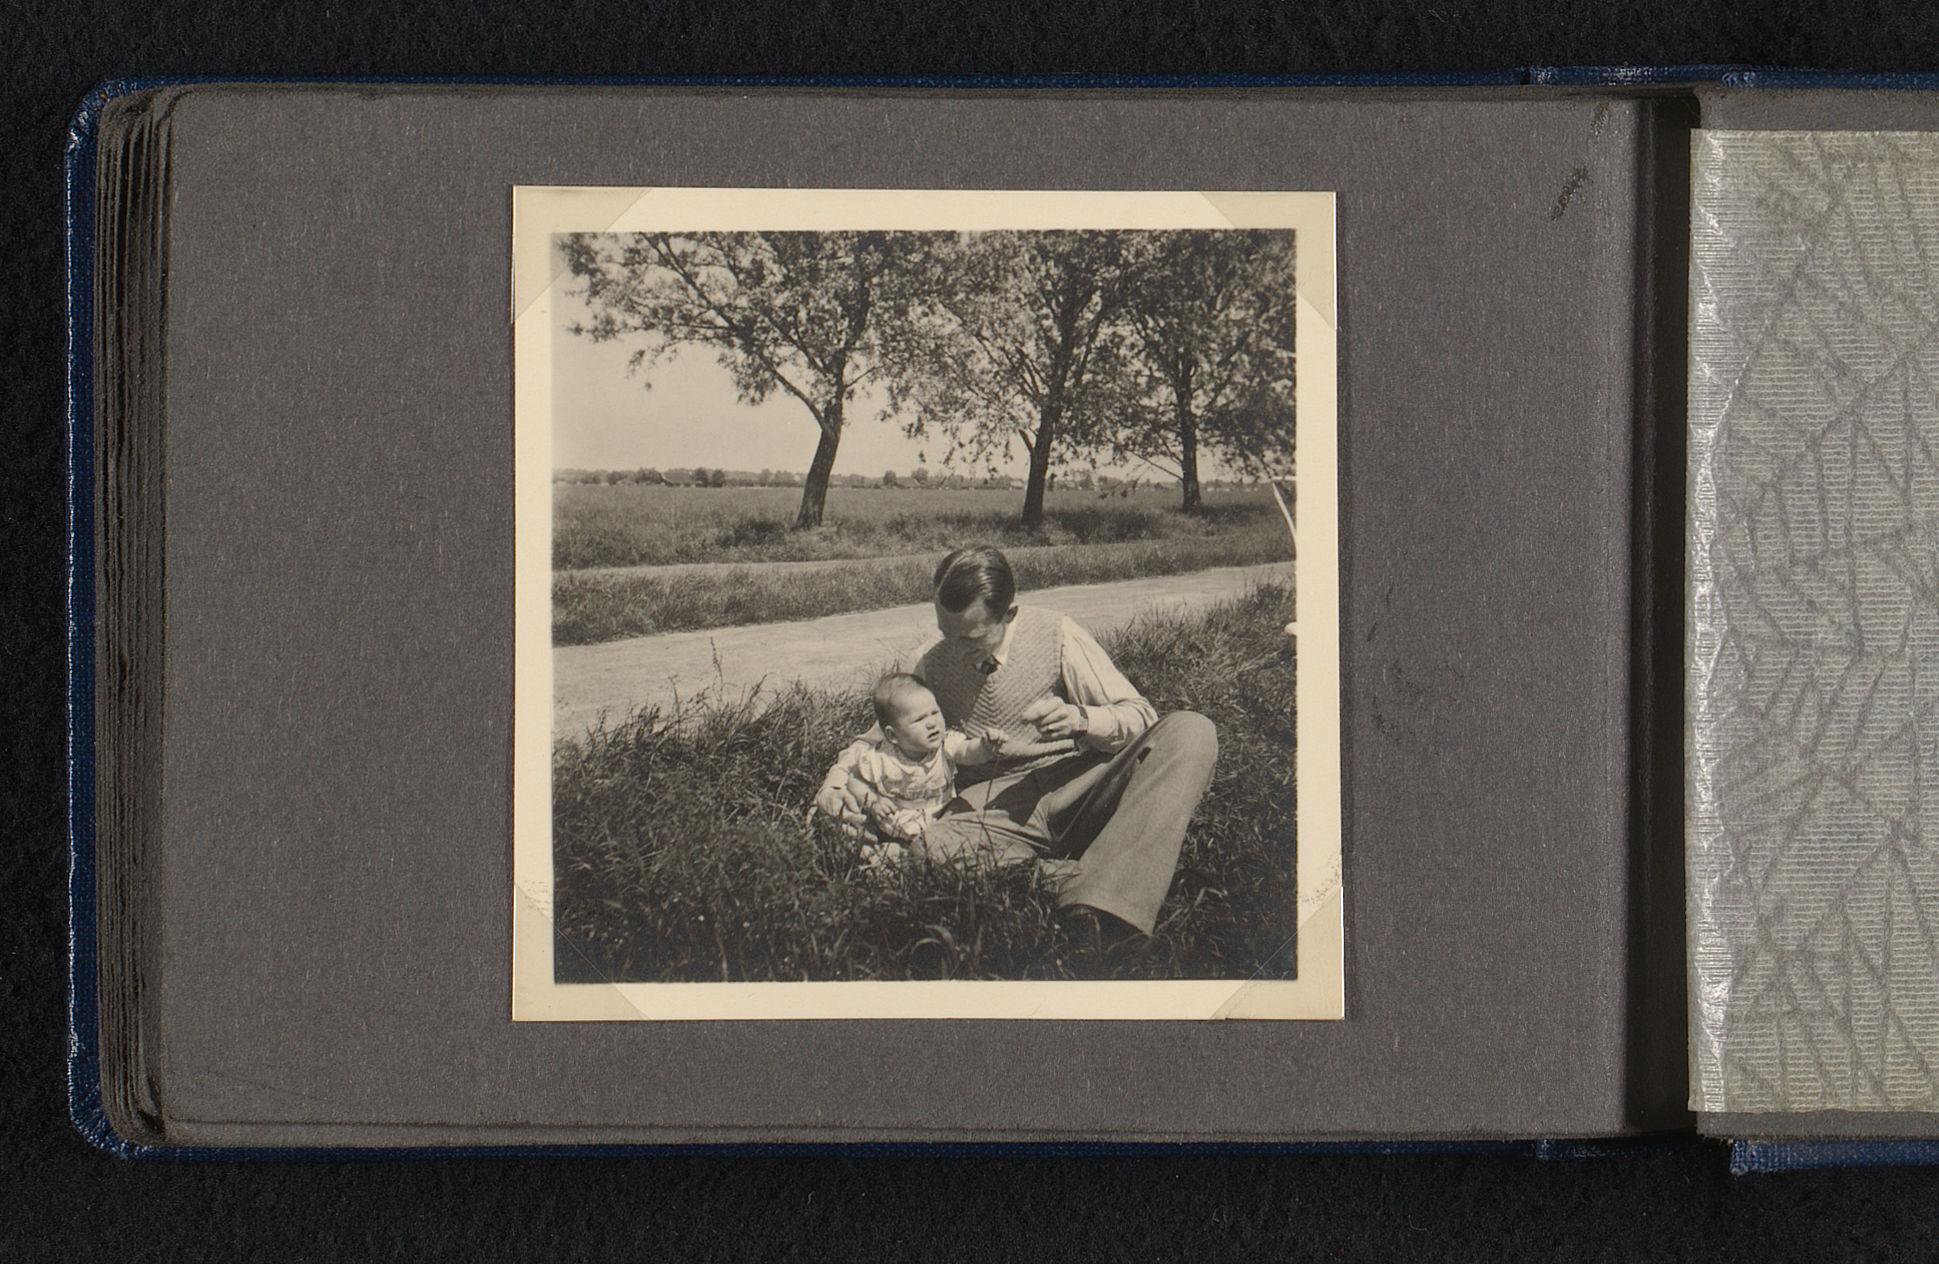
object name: album leaf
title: Frank Willem van den Berg met zoon Norbert als baby zittend in gras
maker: norbert peter van den berg (1941-)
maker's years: 1941-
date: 1941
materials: paper, cardboard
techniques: gelatin silver print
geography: netherlands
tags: norbert peter van den berg (1941-), amsterdam, frank willem van den berg (1912-1998), adult man, sitting on the ground, infant, baby